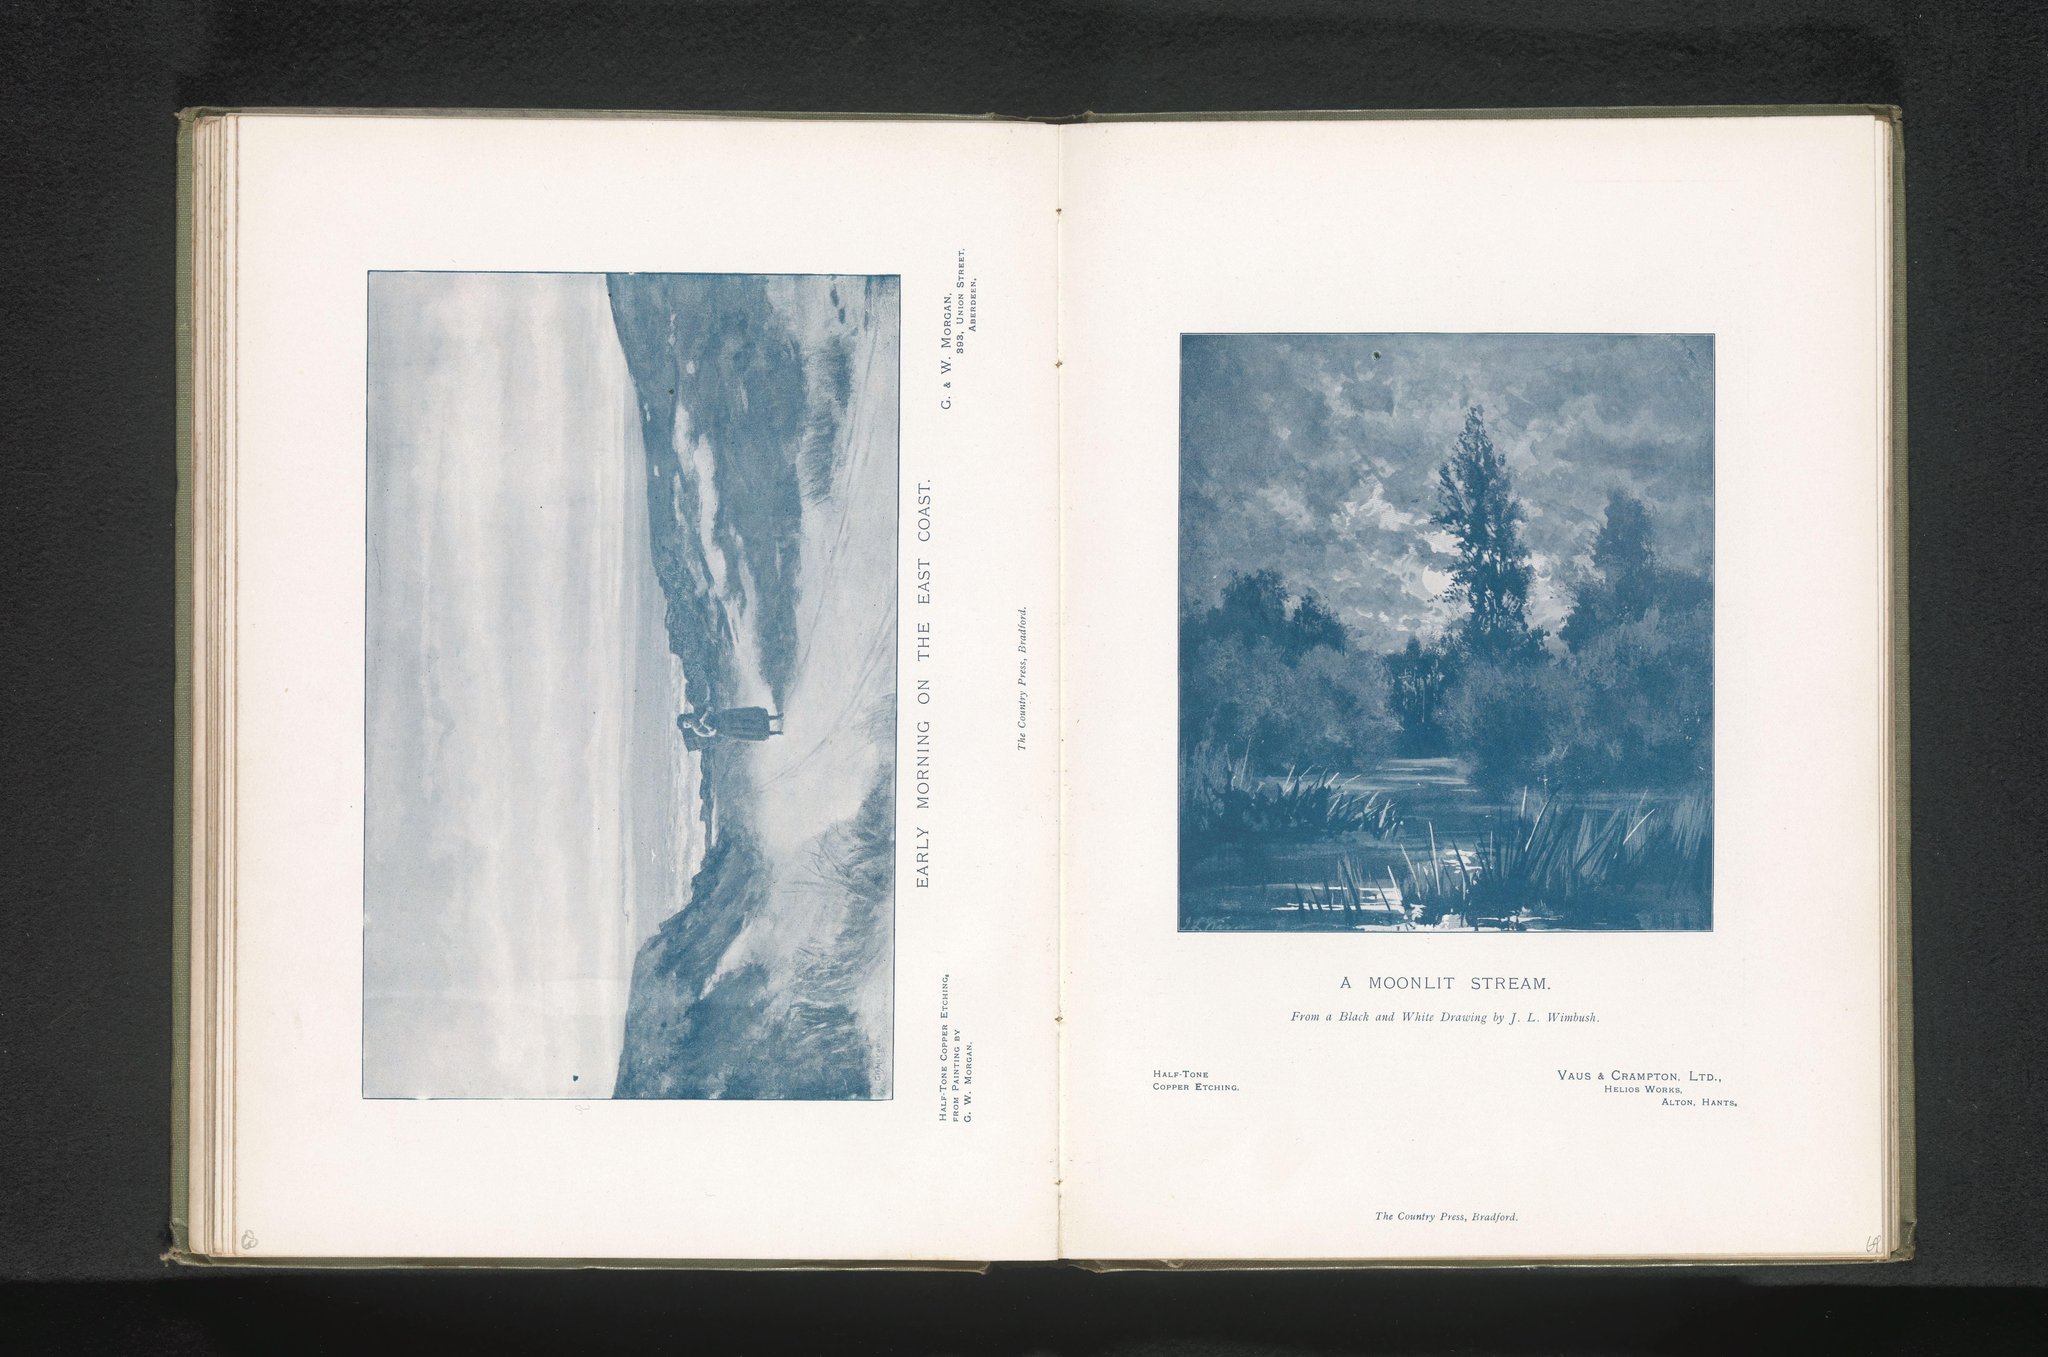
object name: reproduction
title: Early morning on the east coast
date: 1893-1898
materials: paper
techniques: autotype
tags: dune coast (+ landscape with figures, staffage)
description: Prent op tweede ongenummerde pagina na pagina 88.